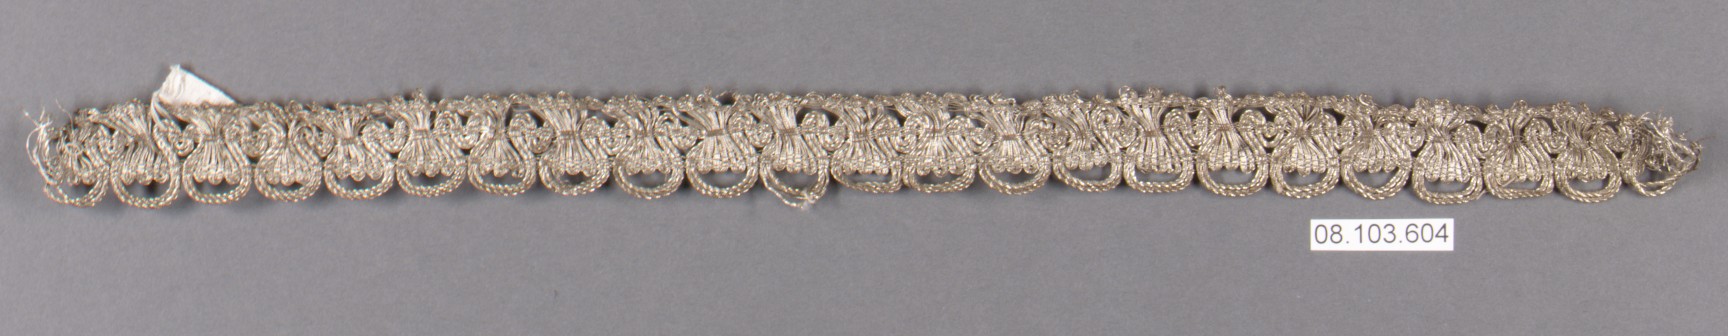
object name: galloon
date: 1701-1800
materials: metal thread